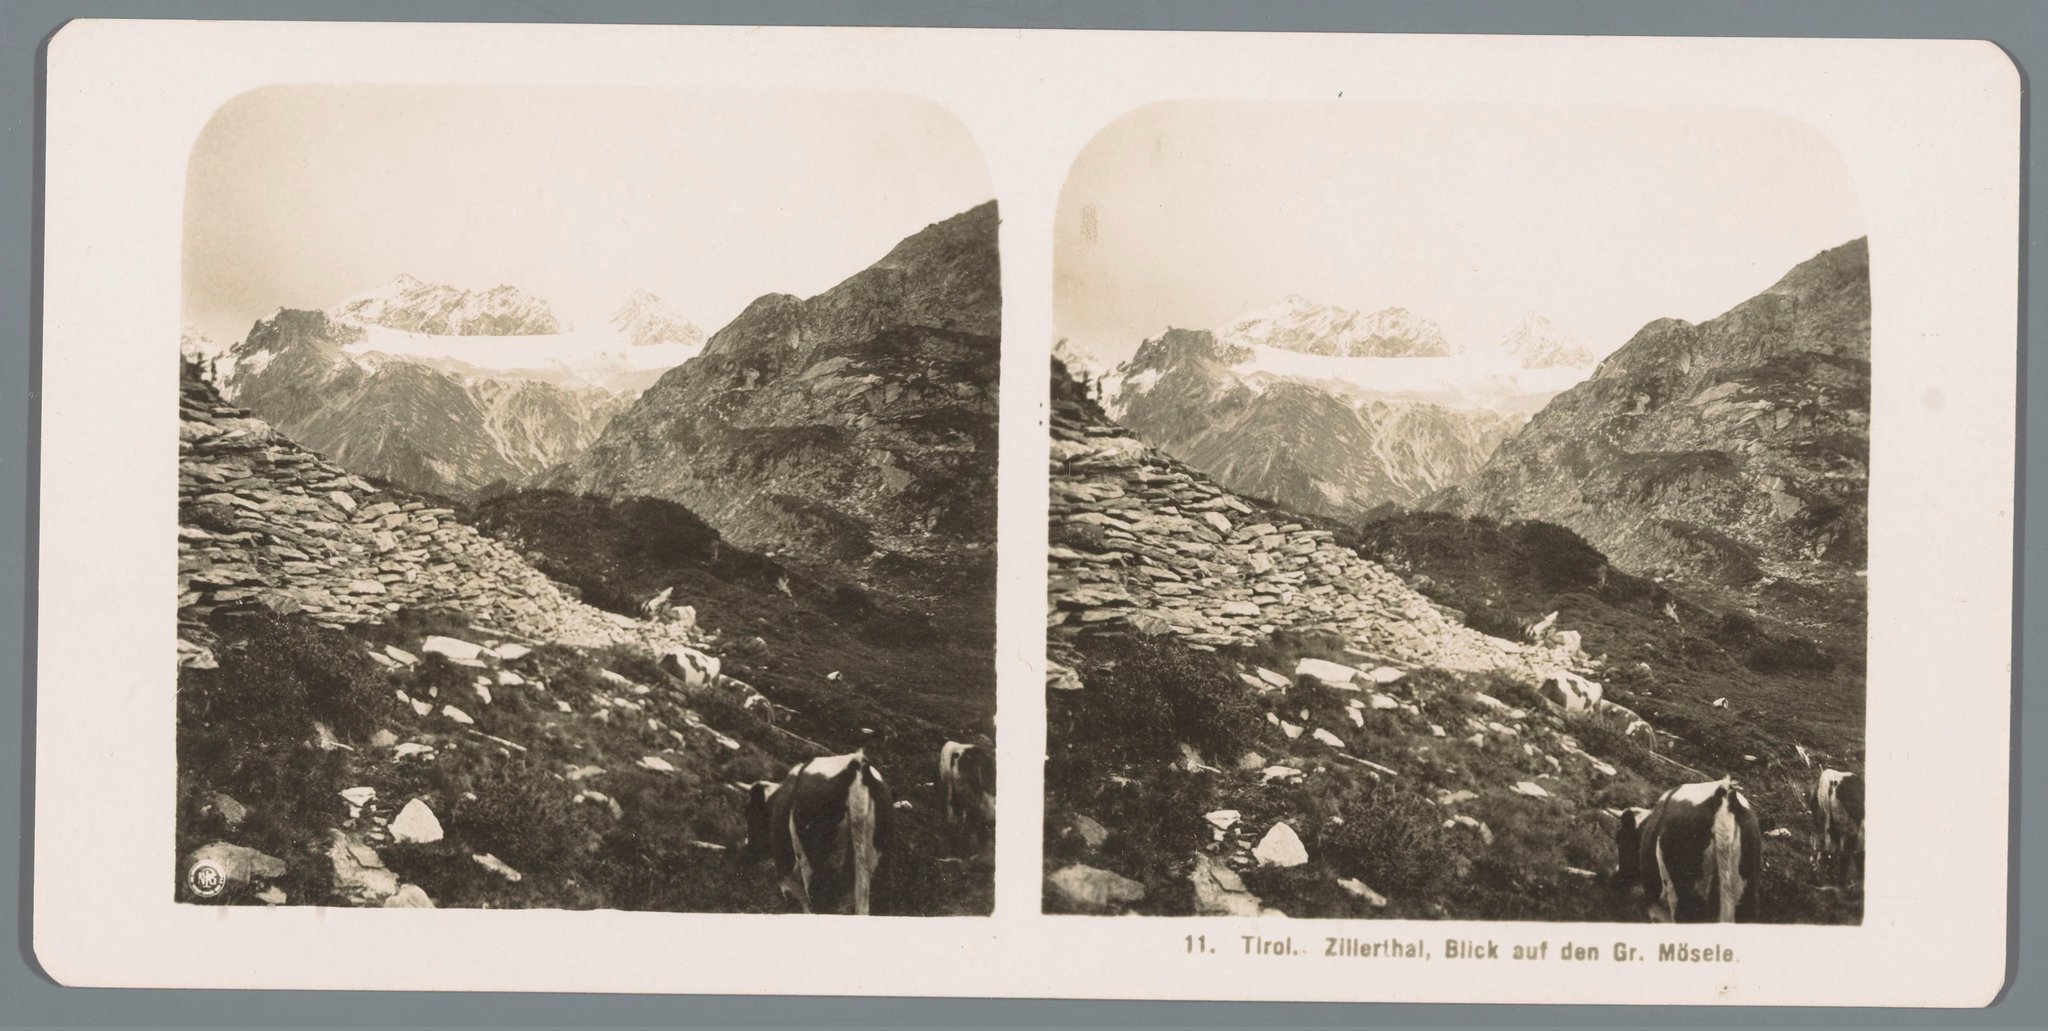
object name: stereograph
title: Gezicht op de Großer Möseler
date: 1900-1910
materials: cardboard, photographic support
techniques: gelatin silver print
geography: tirol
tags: mountain-top, peak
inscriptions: number: ‘11.’, inscription: ‘NPG’